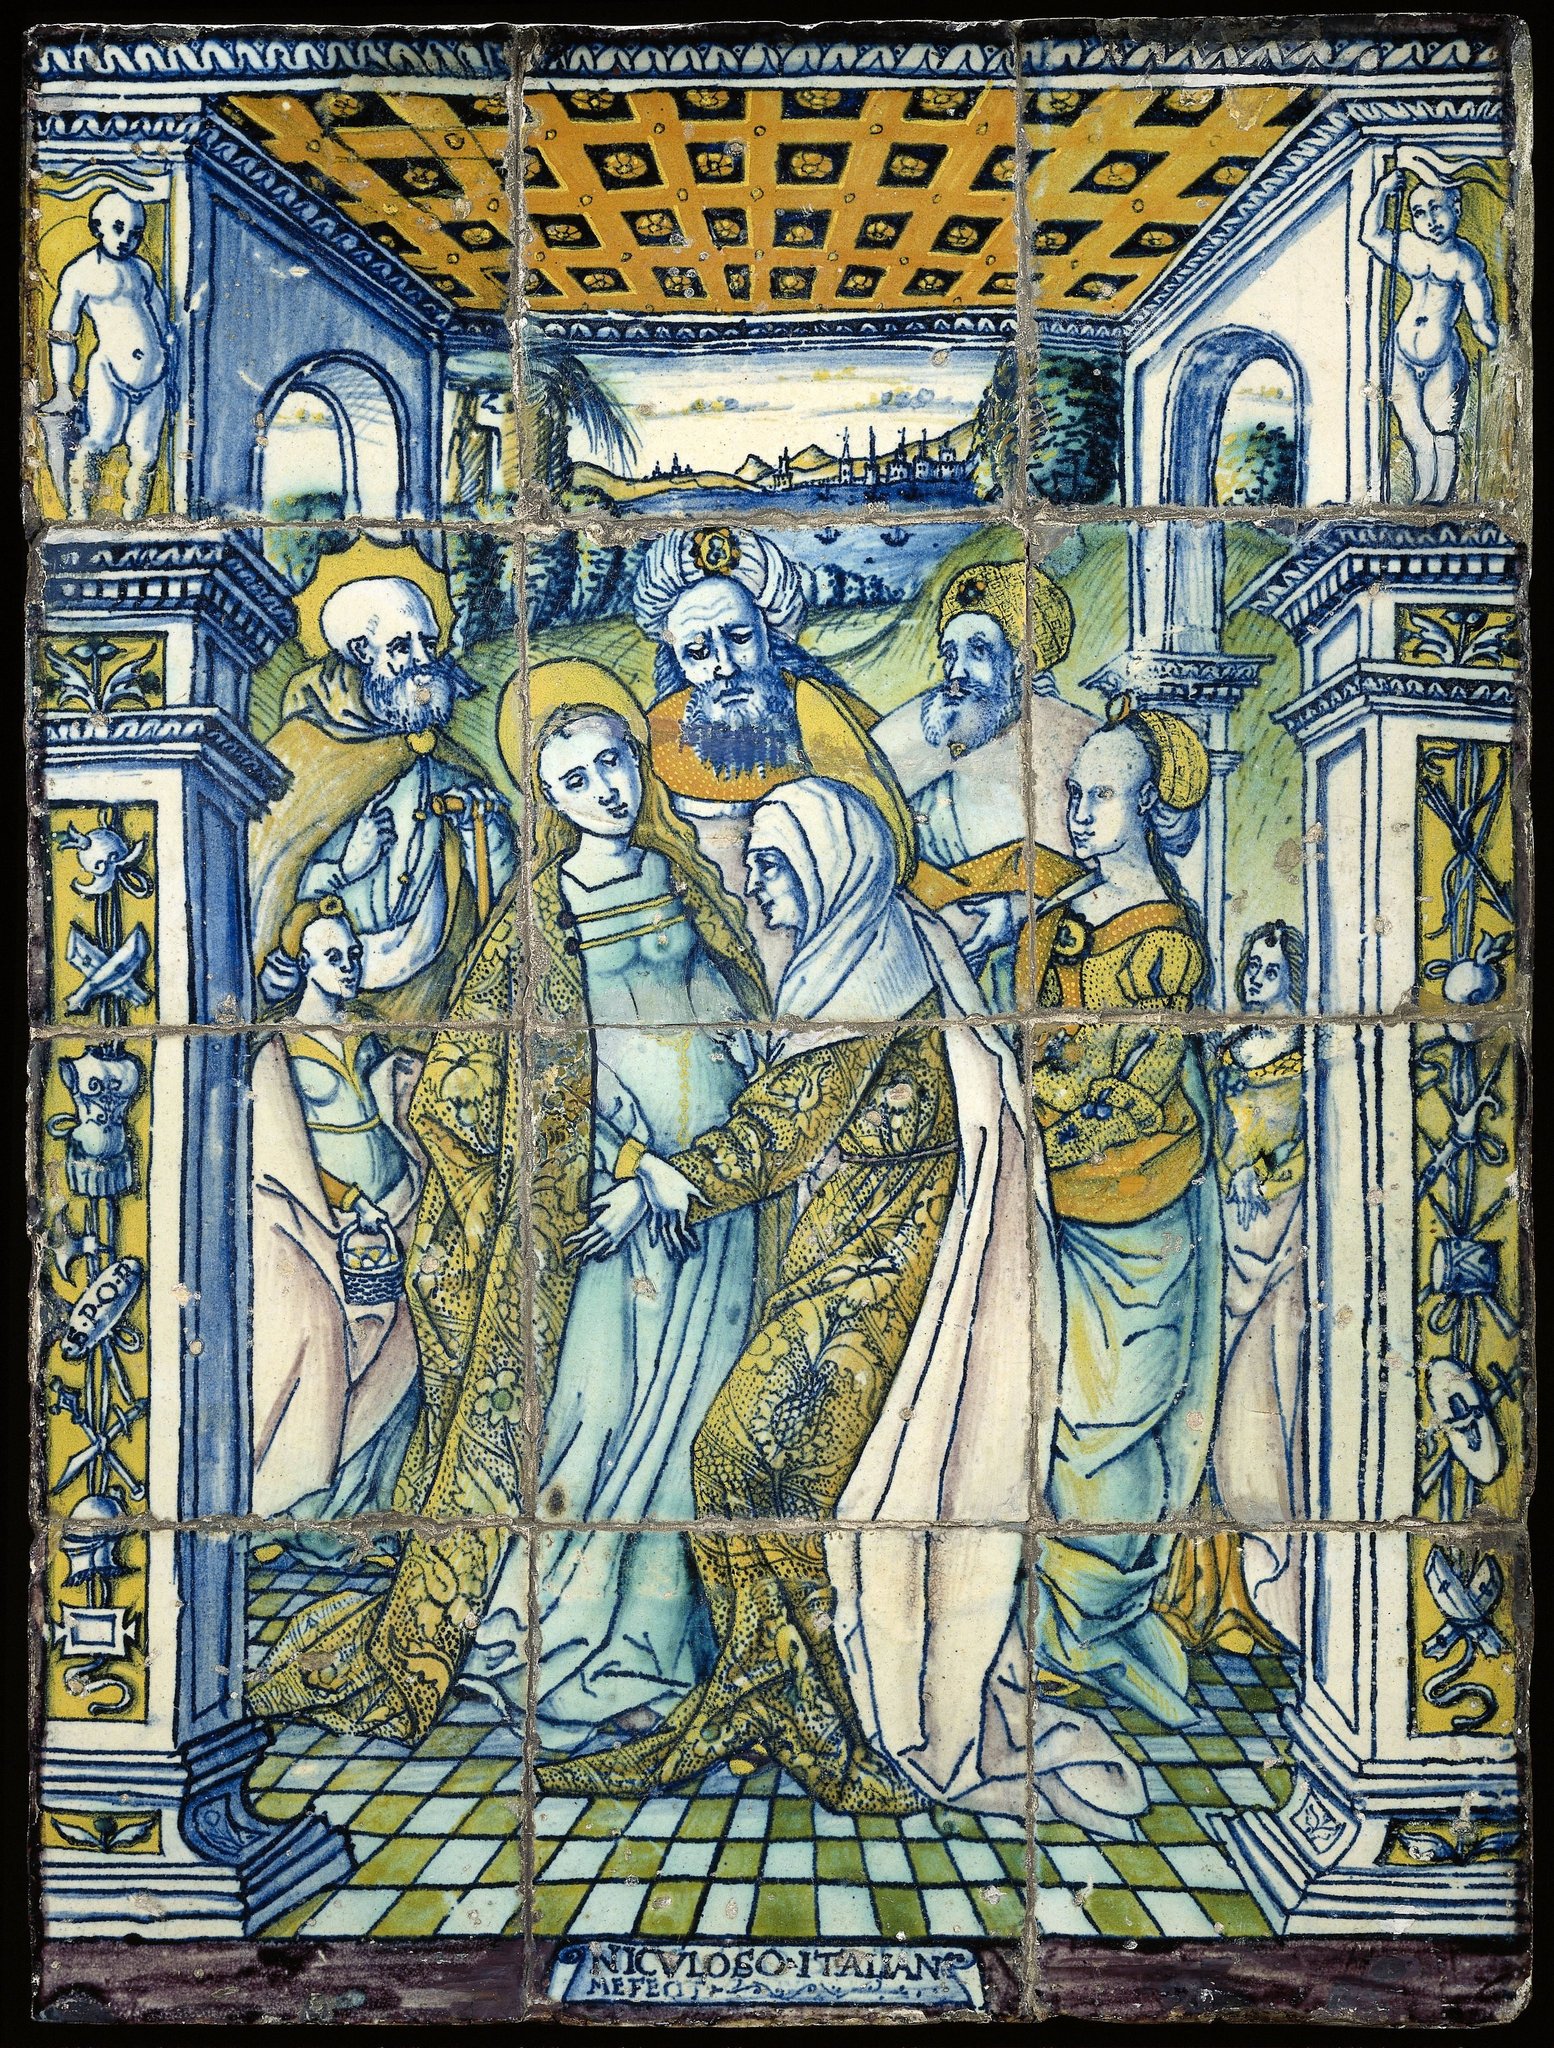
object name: tile tableau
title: Tegeltableau met een voorstelling van de Visitatie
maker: francisco niculoso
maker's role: plateelschilder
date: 1504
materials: earthenware, glaze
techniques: maiolica, painted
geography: sevilla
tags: visitation (possibly joseph and/or zacharias present) (luke 1:39-56)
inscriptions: inscription: ‘NICVLOSO ITALIANO // ME FECIT’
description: Tile picture The Visitation (the visit of the Virgin Mary after the Annunciation to her cousin Elizabeth, mother-to-be of John the Baptist). Maiolica. Spain, Seville, Francisco Niculoso called Pisano, 1504.